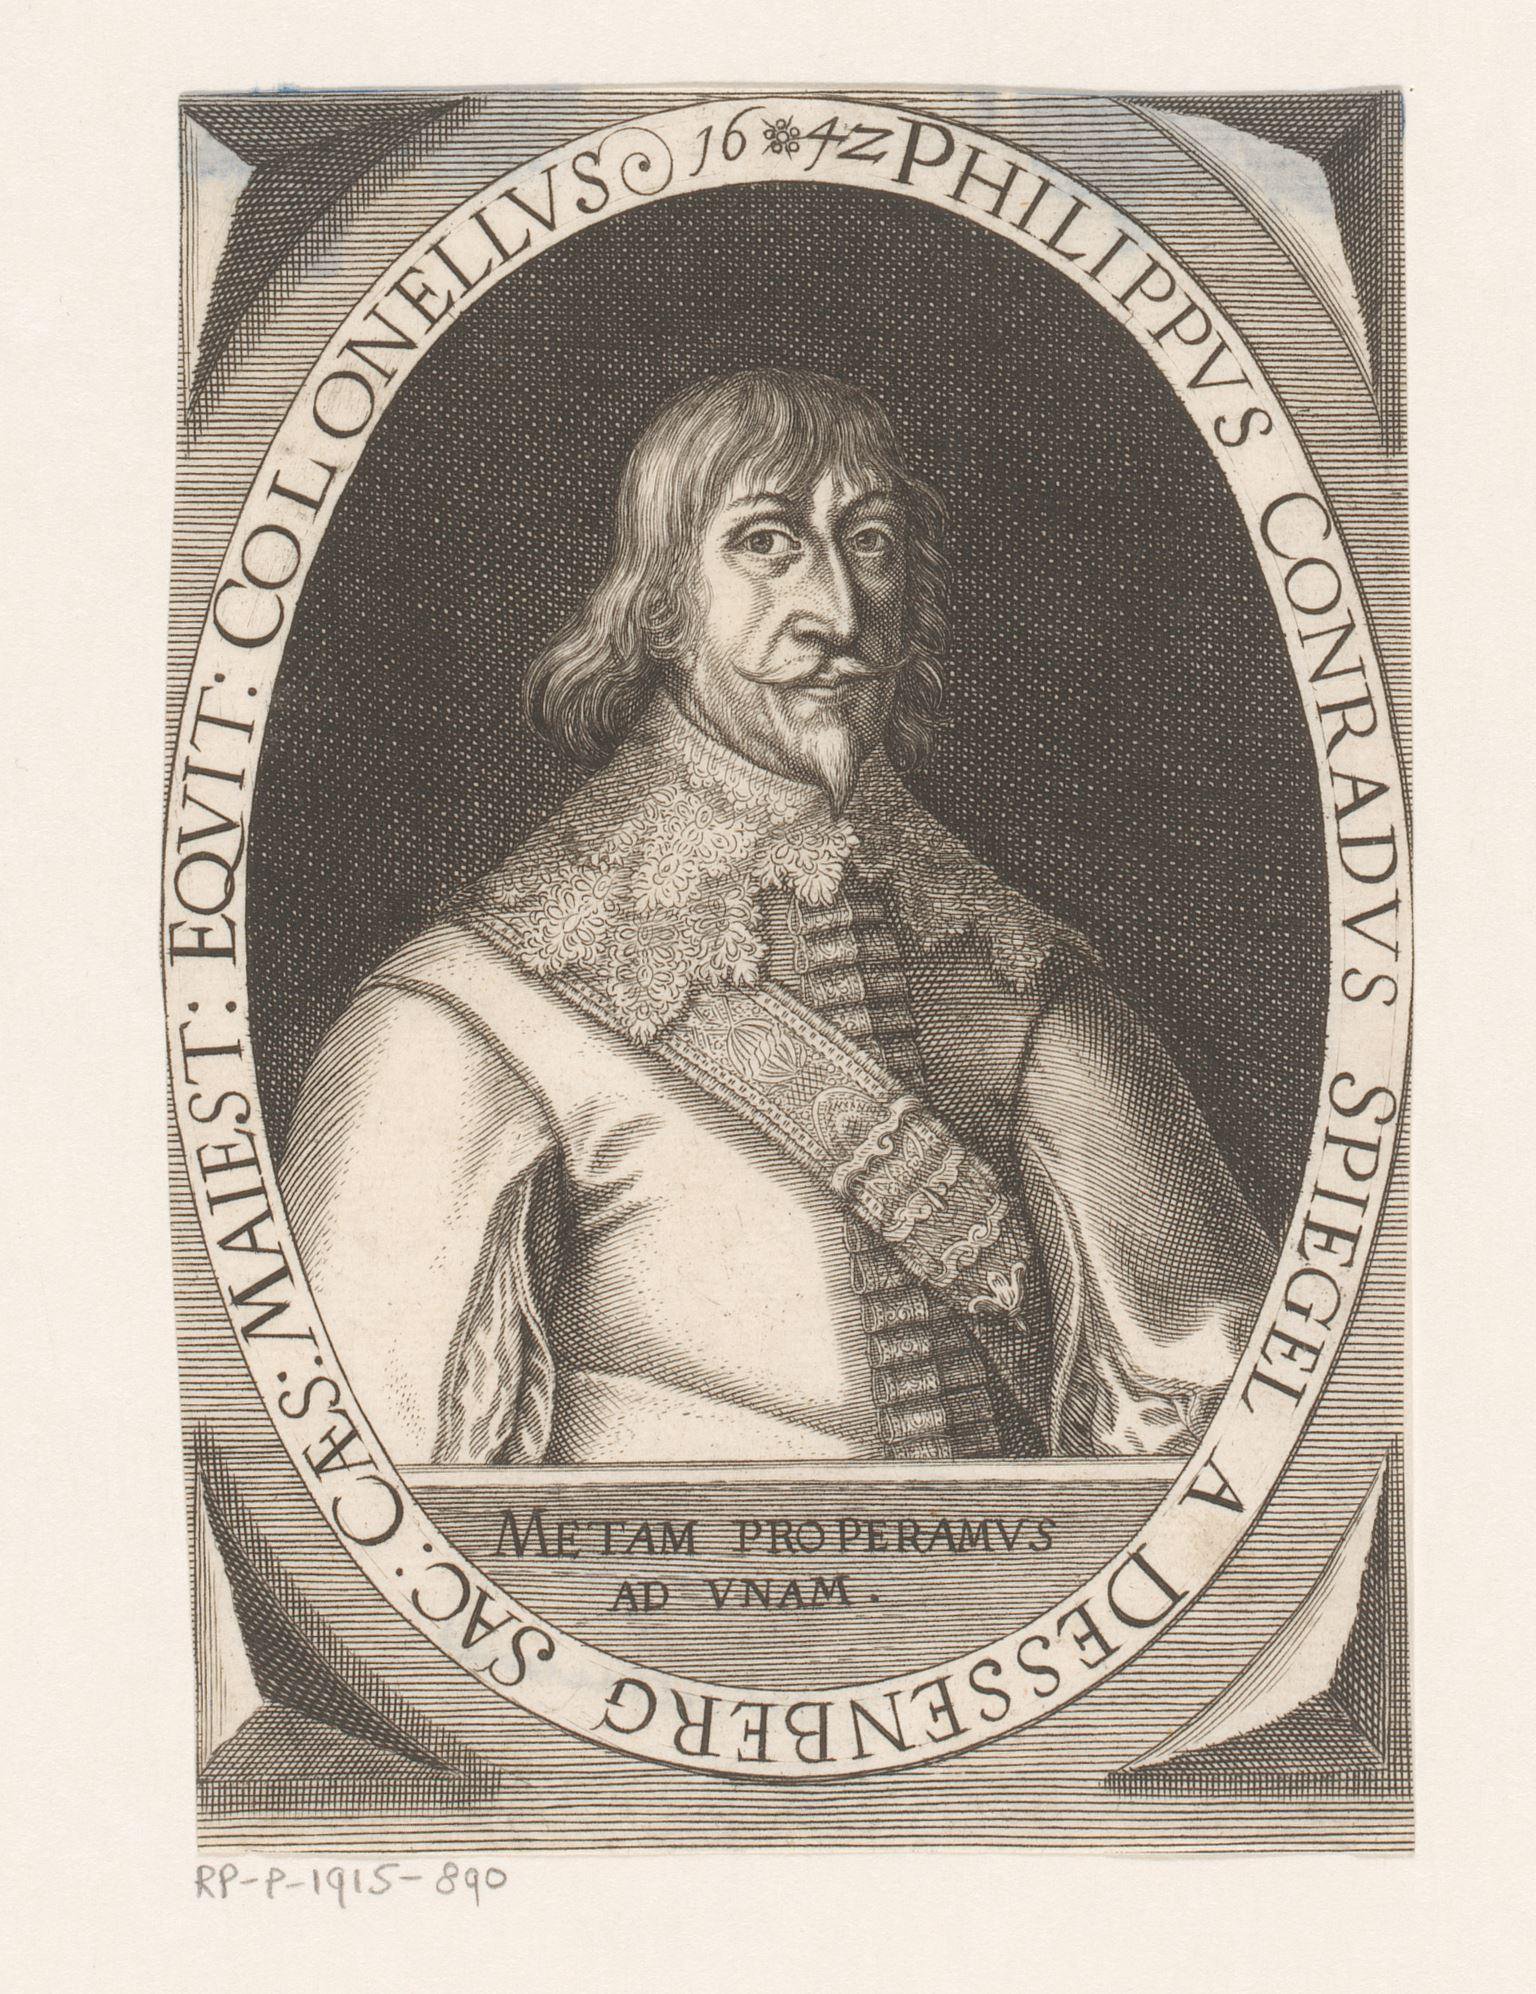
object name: print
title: Portret van Philipp Konrad Spiegel zum Diesenberg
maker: elias widemann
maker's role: print maker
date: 1642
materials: paper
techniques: engraving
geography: vienna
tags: historical persons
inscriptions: collector's mark: Lugt 2228